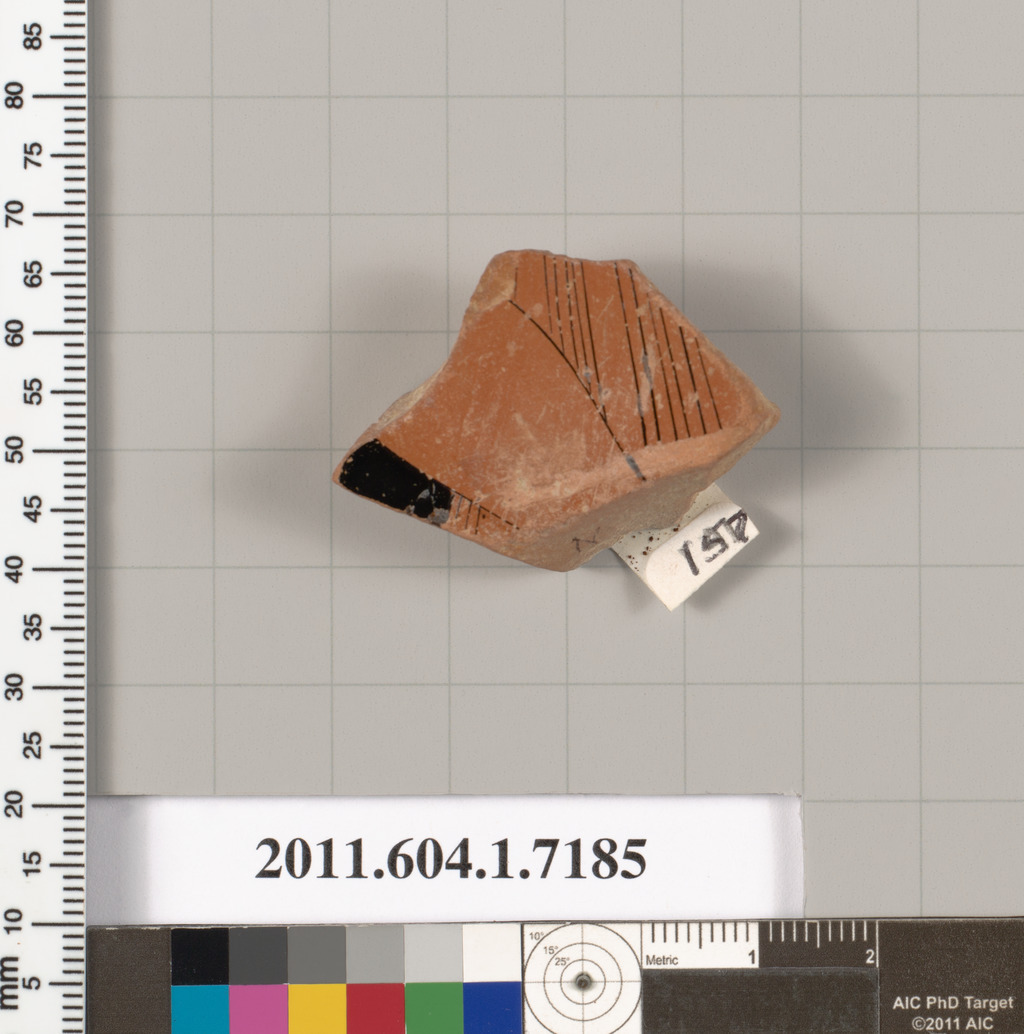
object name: kylix fragment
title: Terracotta fragment of a kylix (drinking cup)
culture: greek, attic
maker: makron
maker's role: artist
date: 500-480 BCE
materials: terracotta